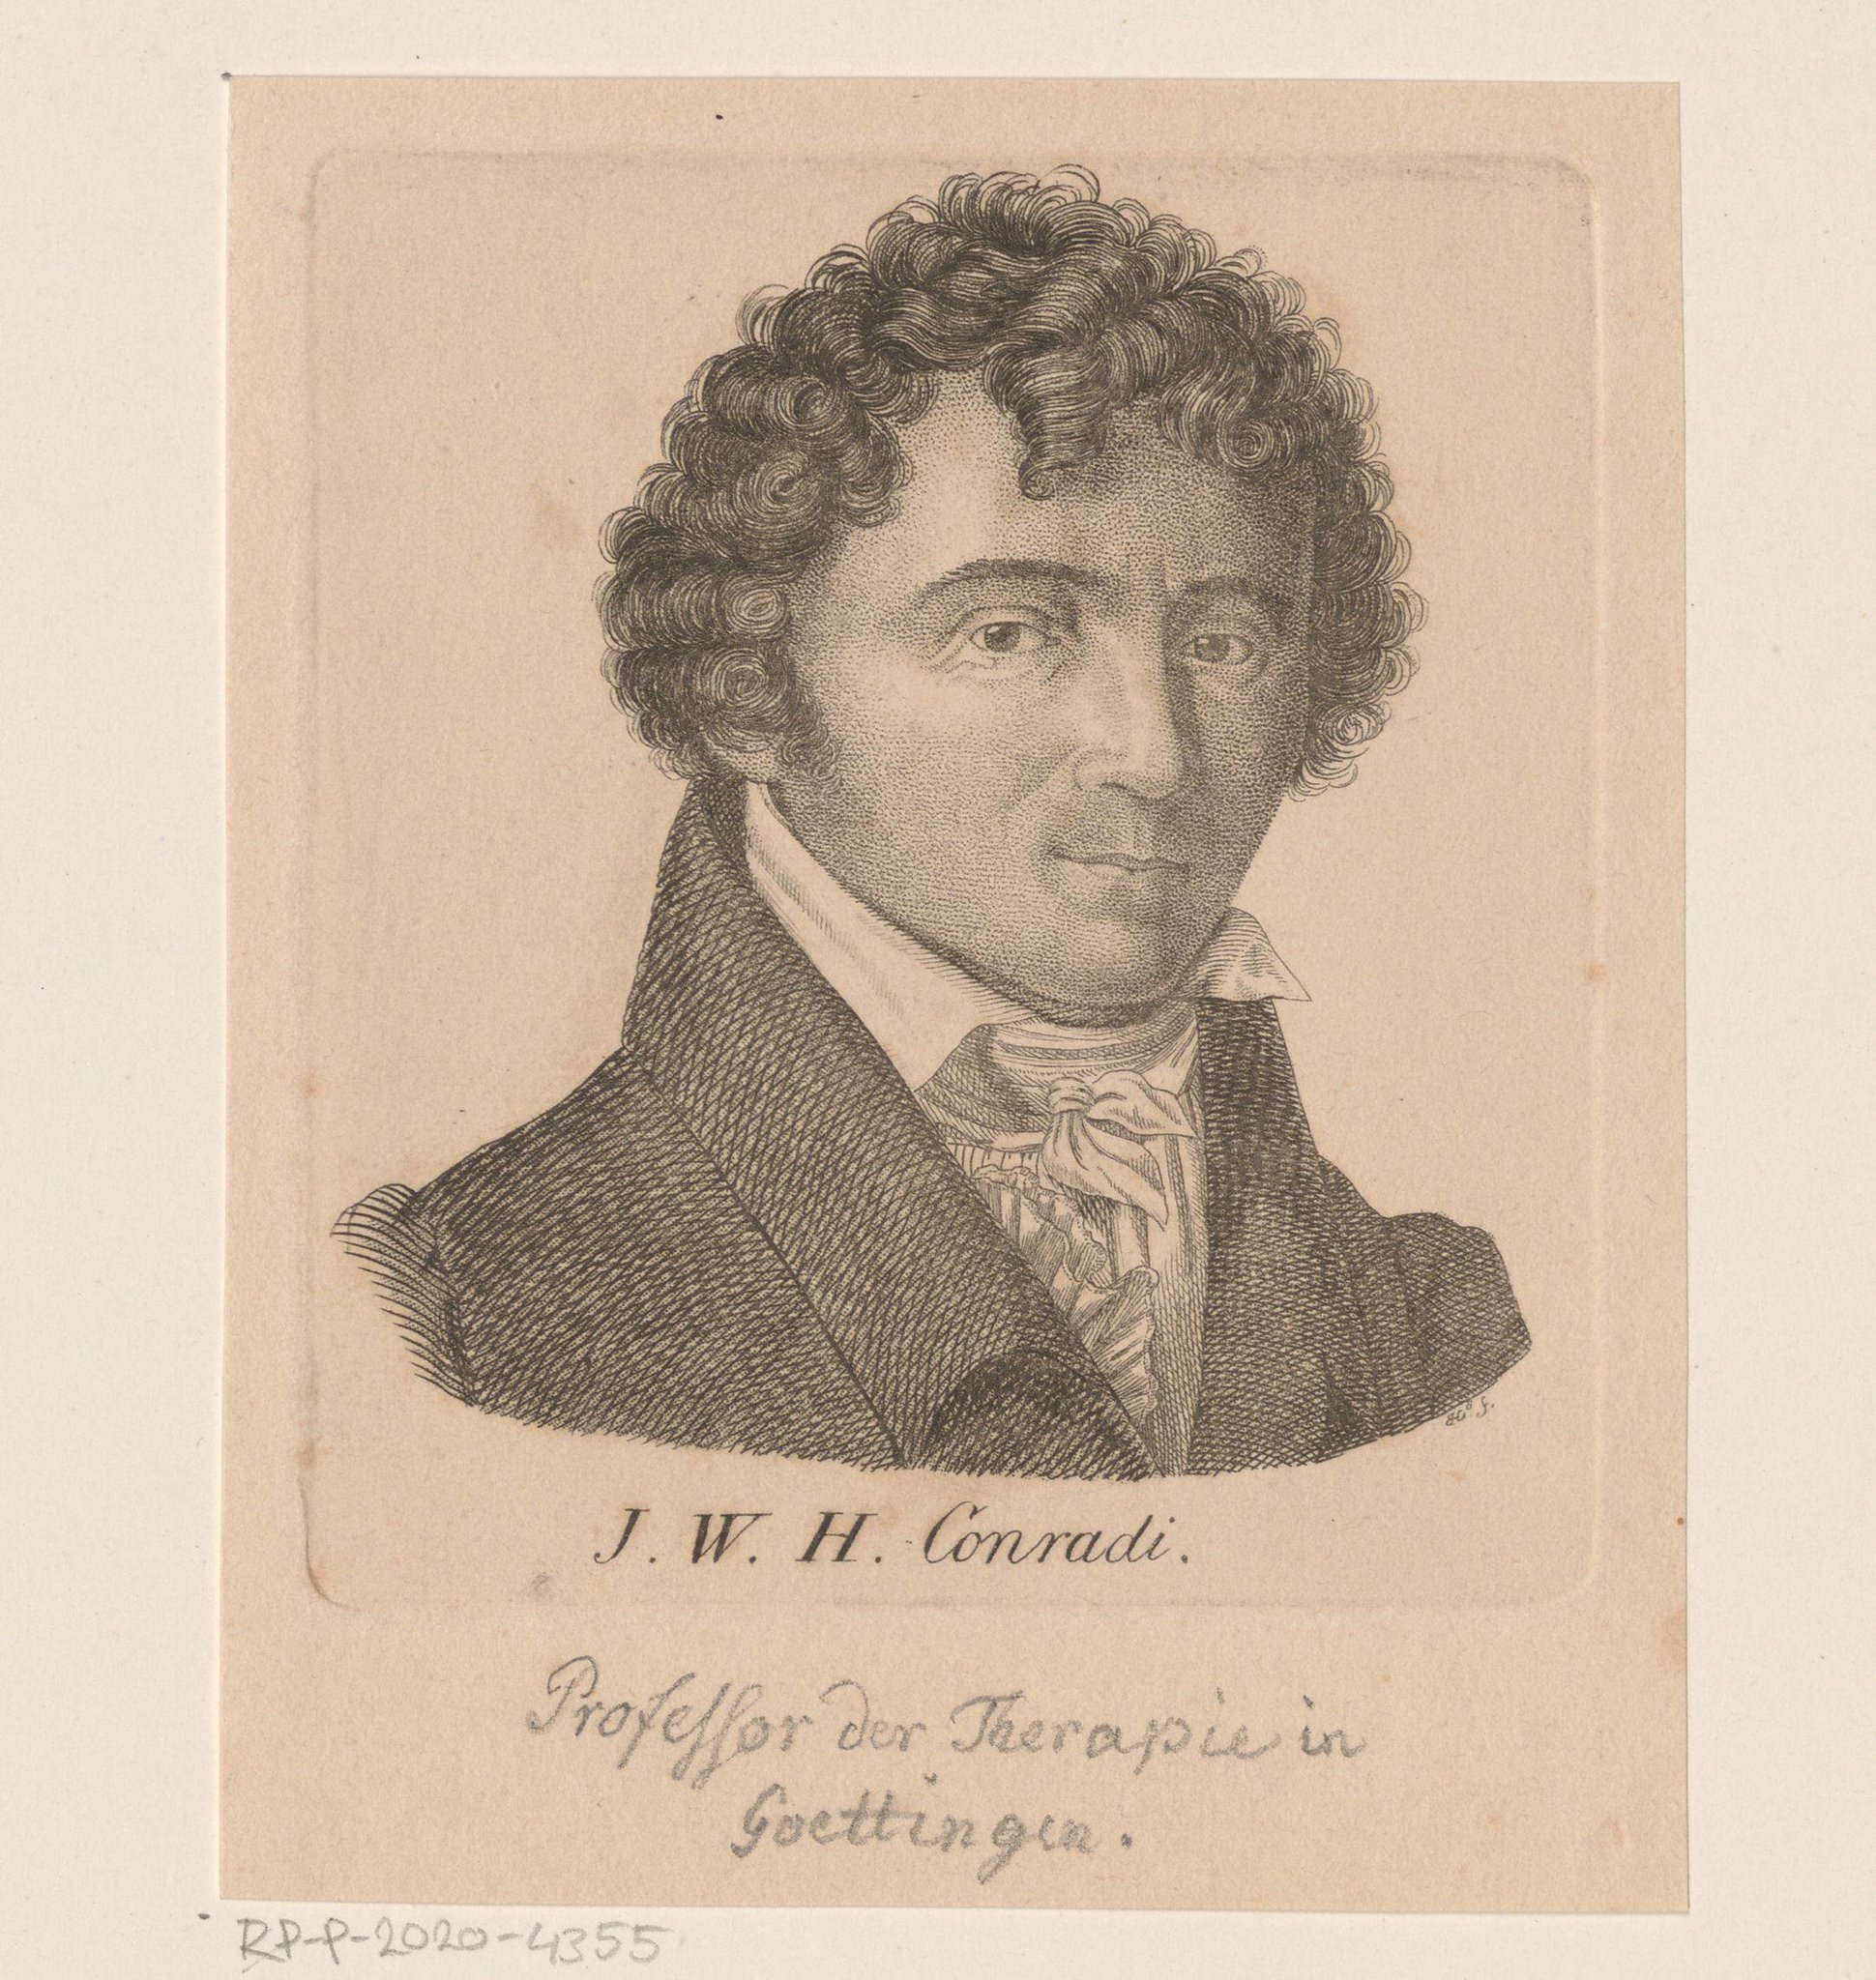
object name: print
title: Portret van Johann Wilhelm Heinrich Conradi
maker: monogrammist fg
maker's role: print maker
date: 1800-1849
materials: paper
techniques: engraving, etching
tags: historical persons